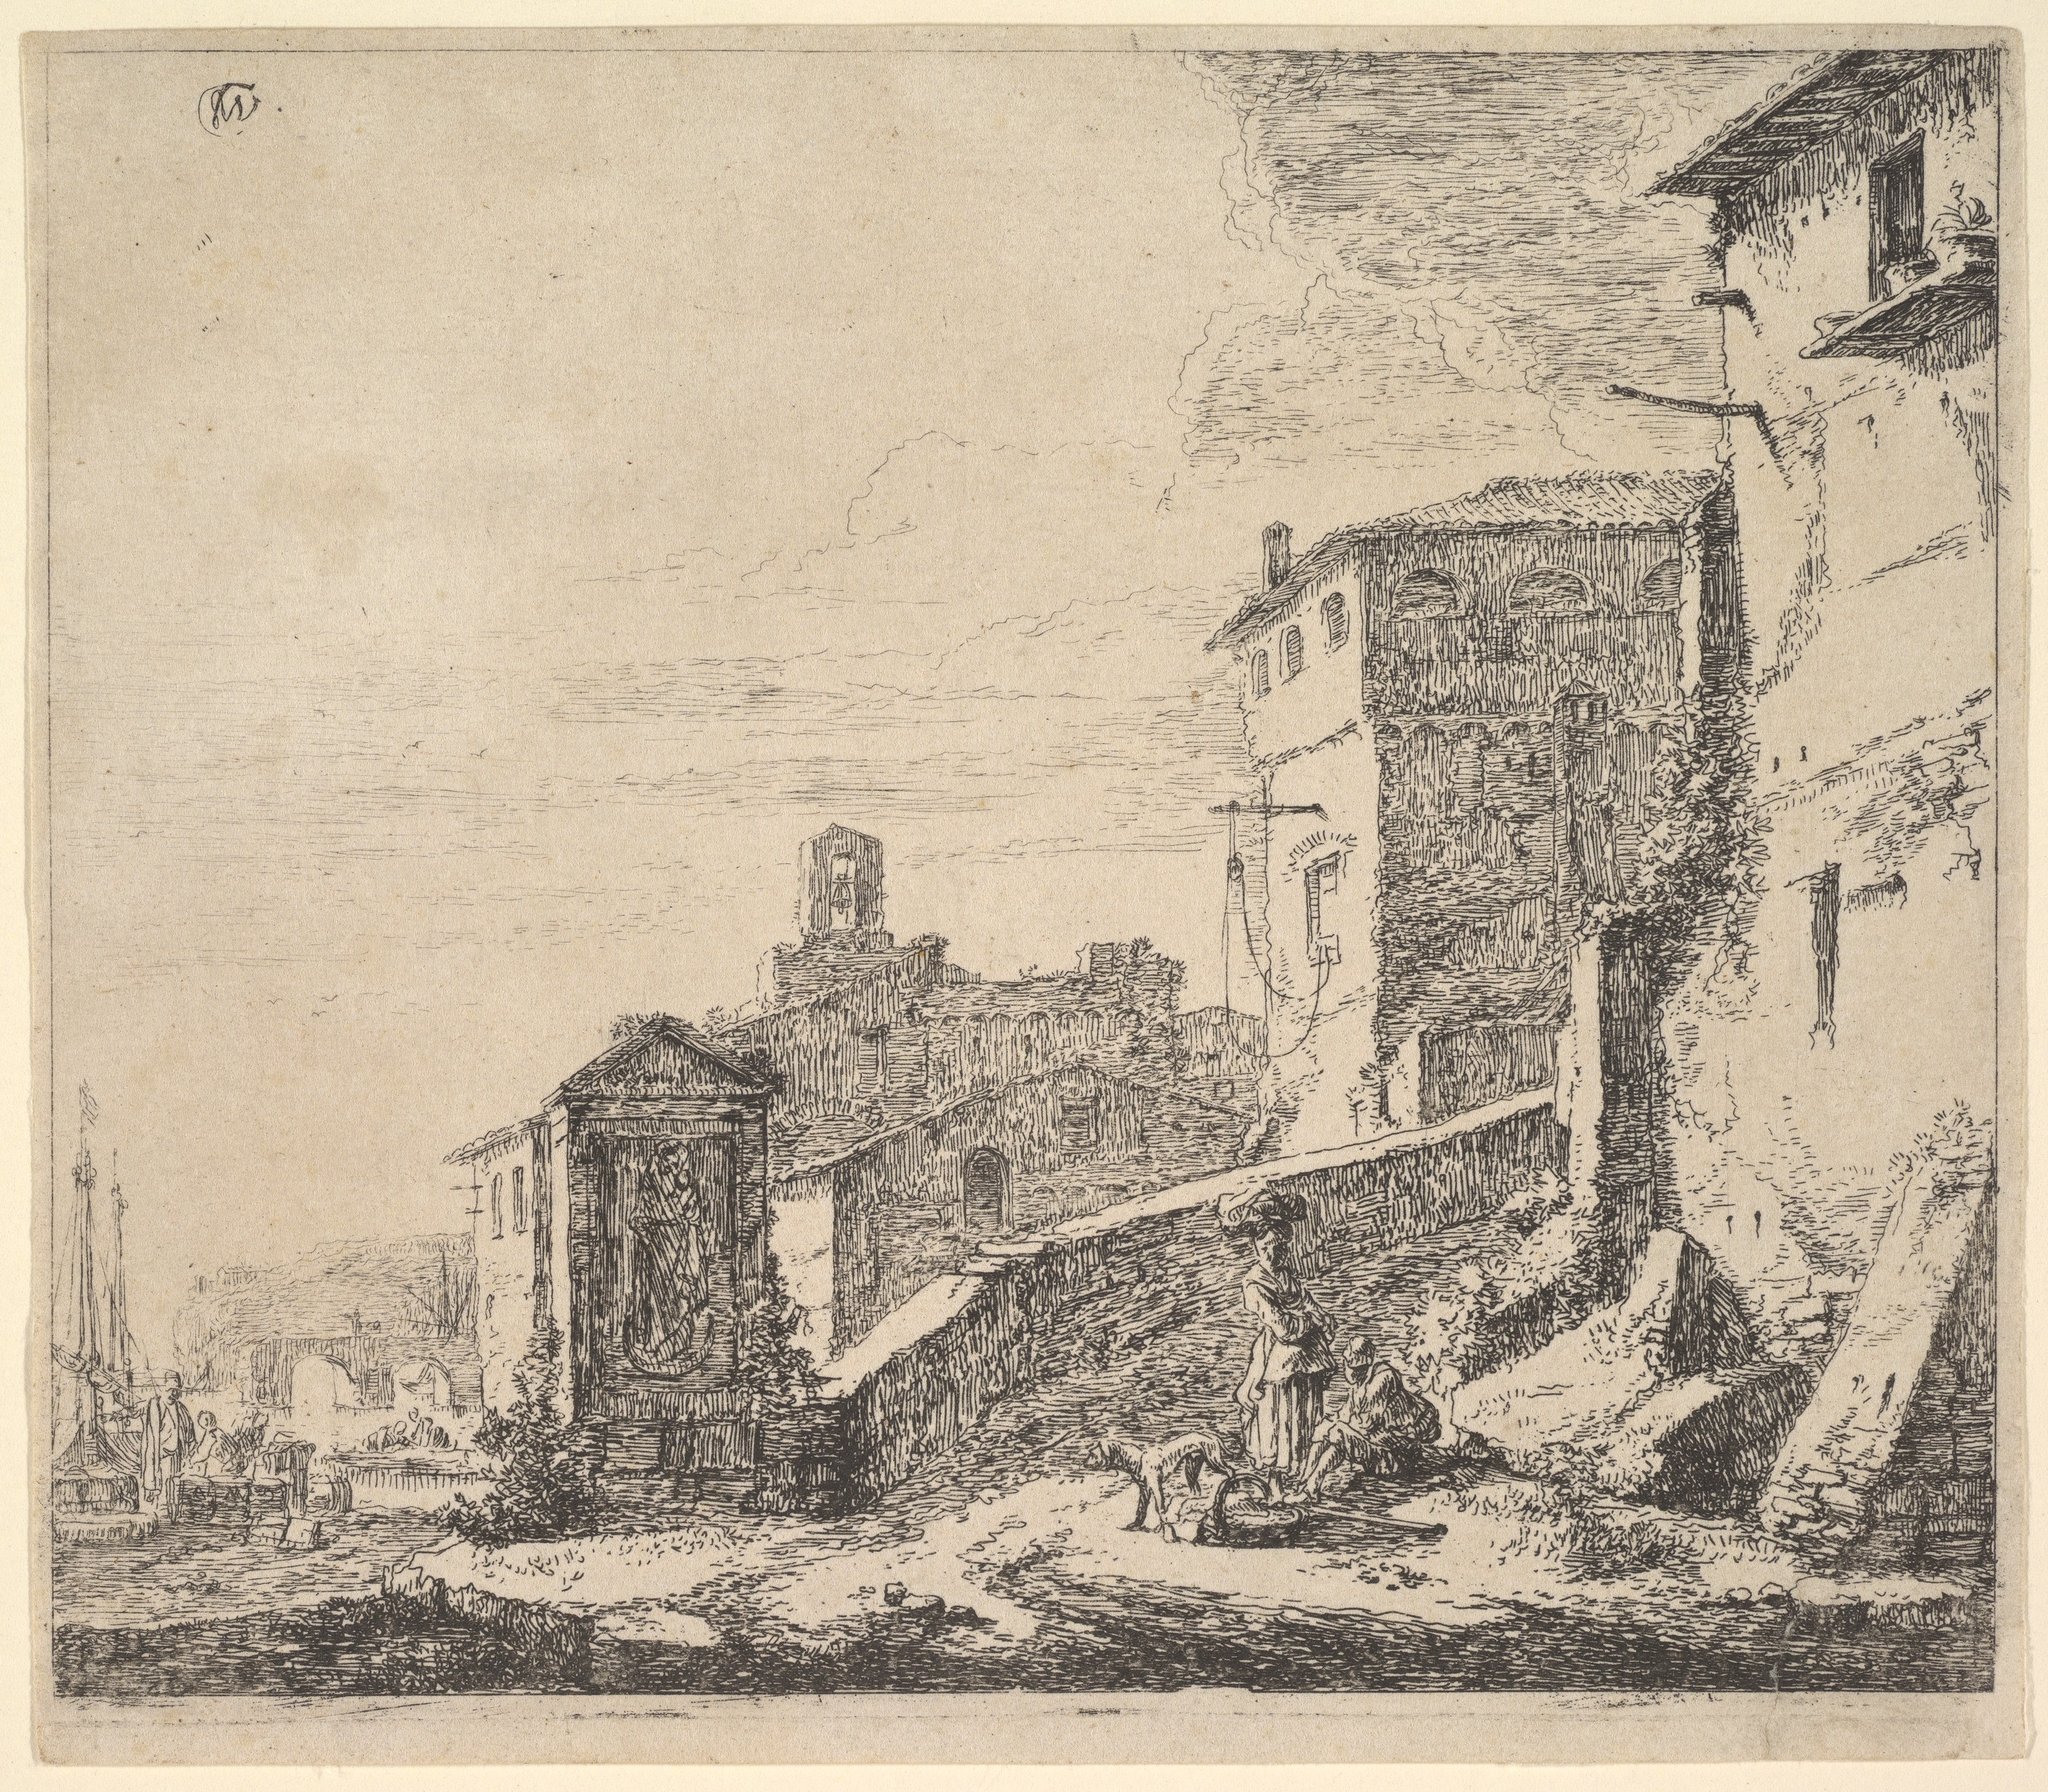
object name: print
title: A Woman Standing by a Seated Man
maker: thomas wijck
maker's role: artist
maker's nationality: dutch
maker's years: 1616-1677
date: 1616-1677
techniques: etching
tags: buildings,men,women